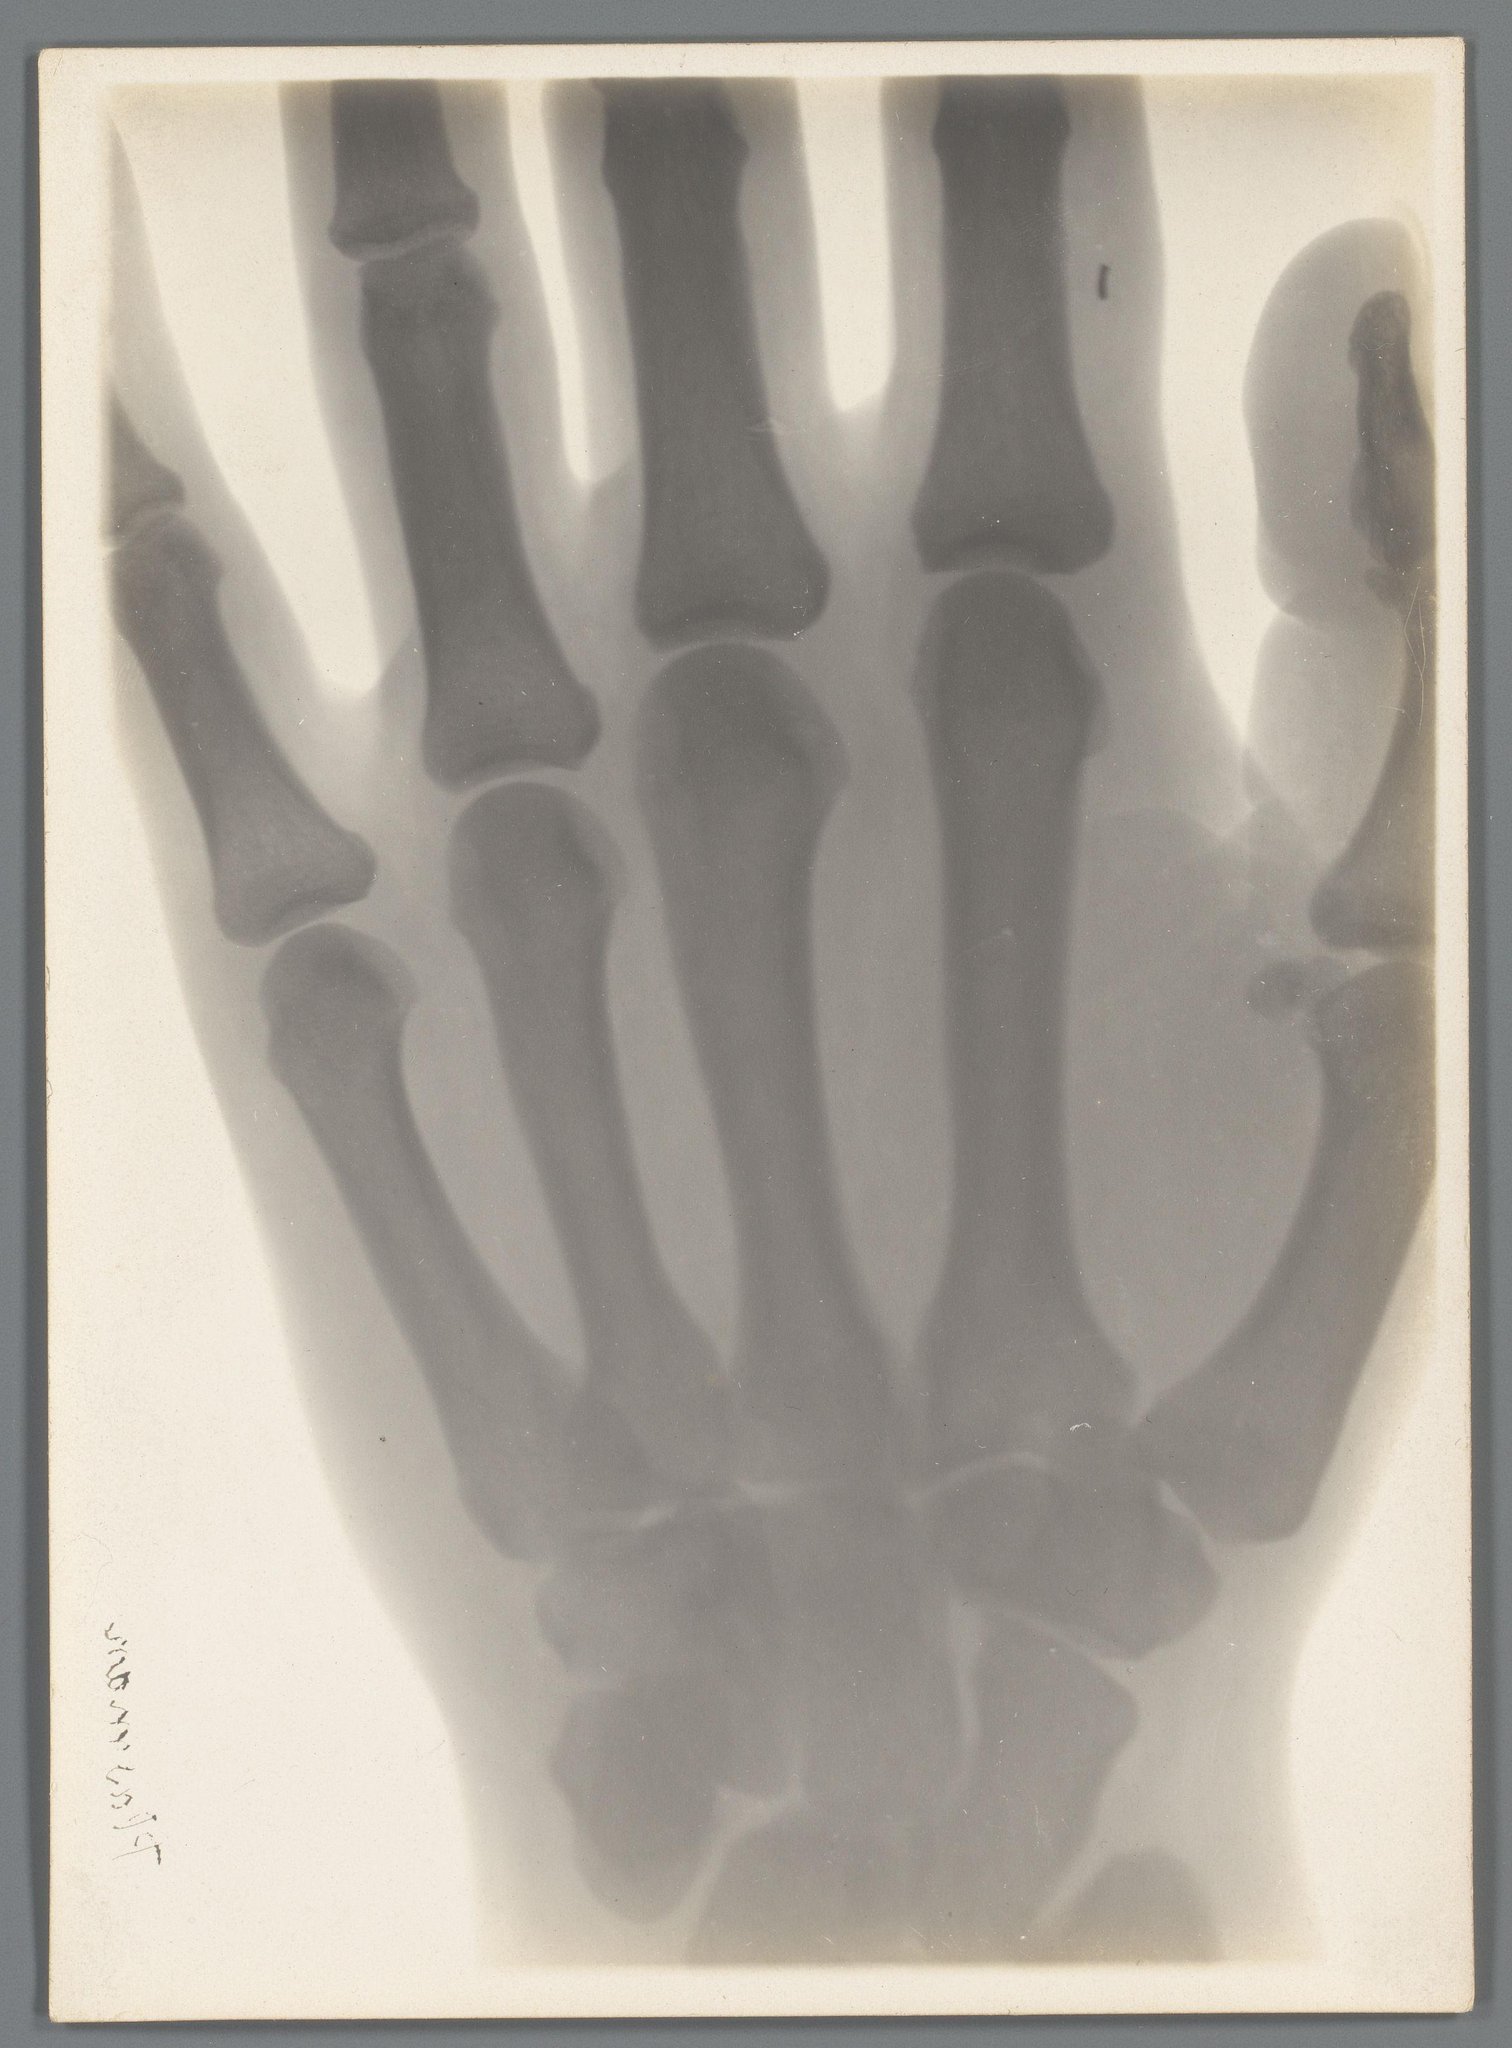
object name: x ray photograph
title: Hand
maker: jacob olie jr.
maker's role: fotograaf, scheikundige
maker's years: 1879-1955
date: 1901-1916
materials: paper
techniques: gelatin silver print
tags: hand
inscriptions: inscription: ‘Plasman’